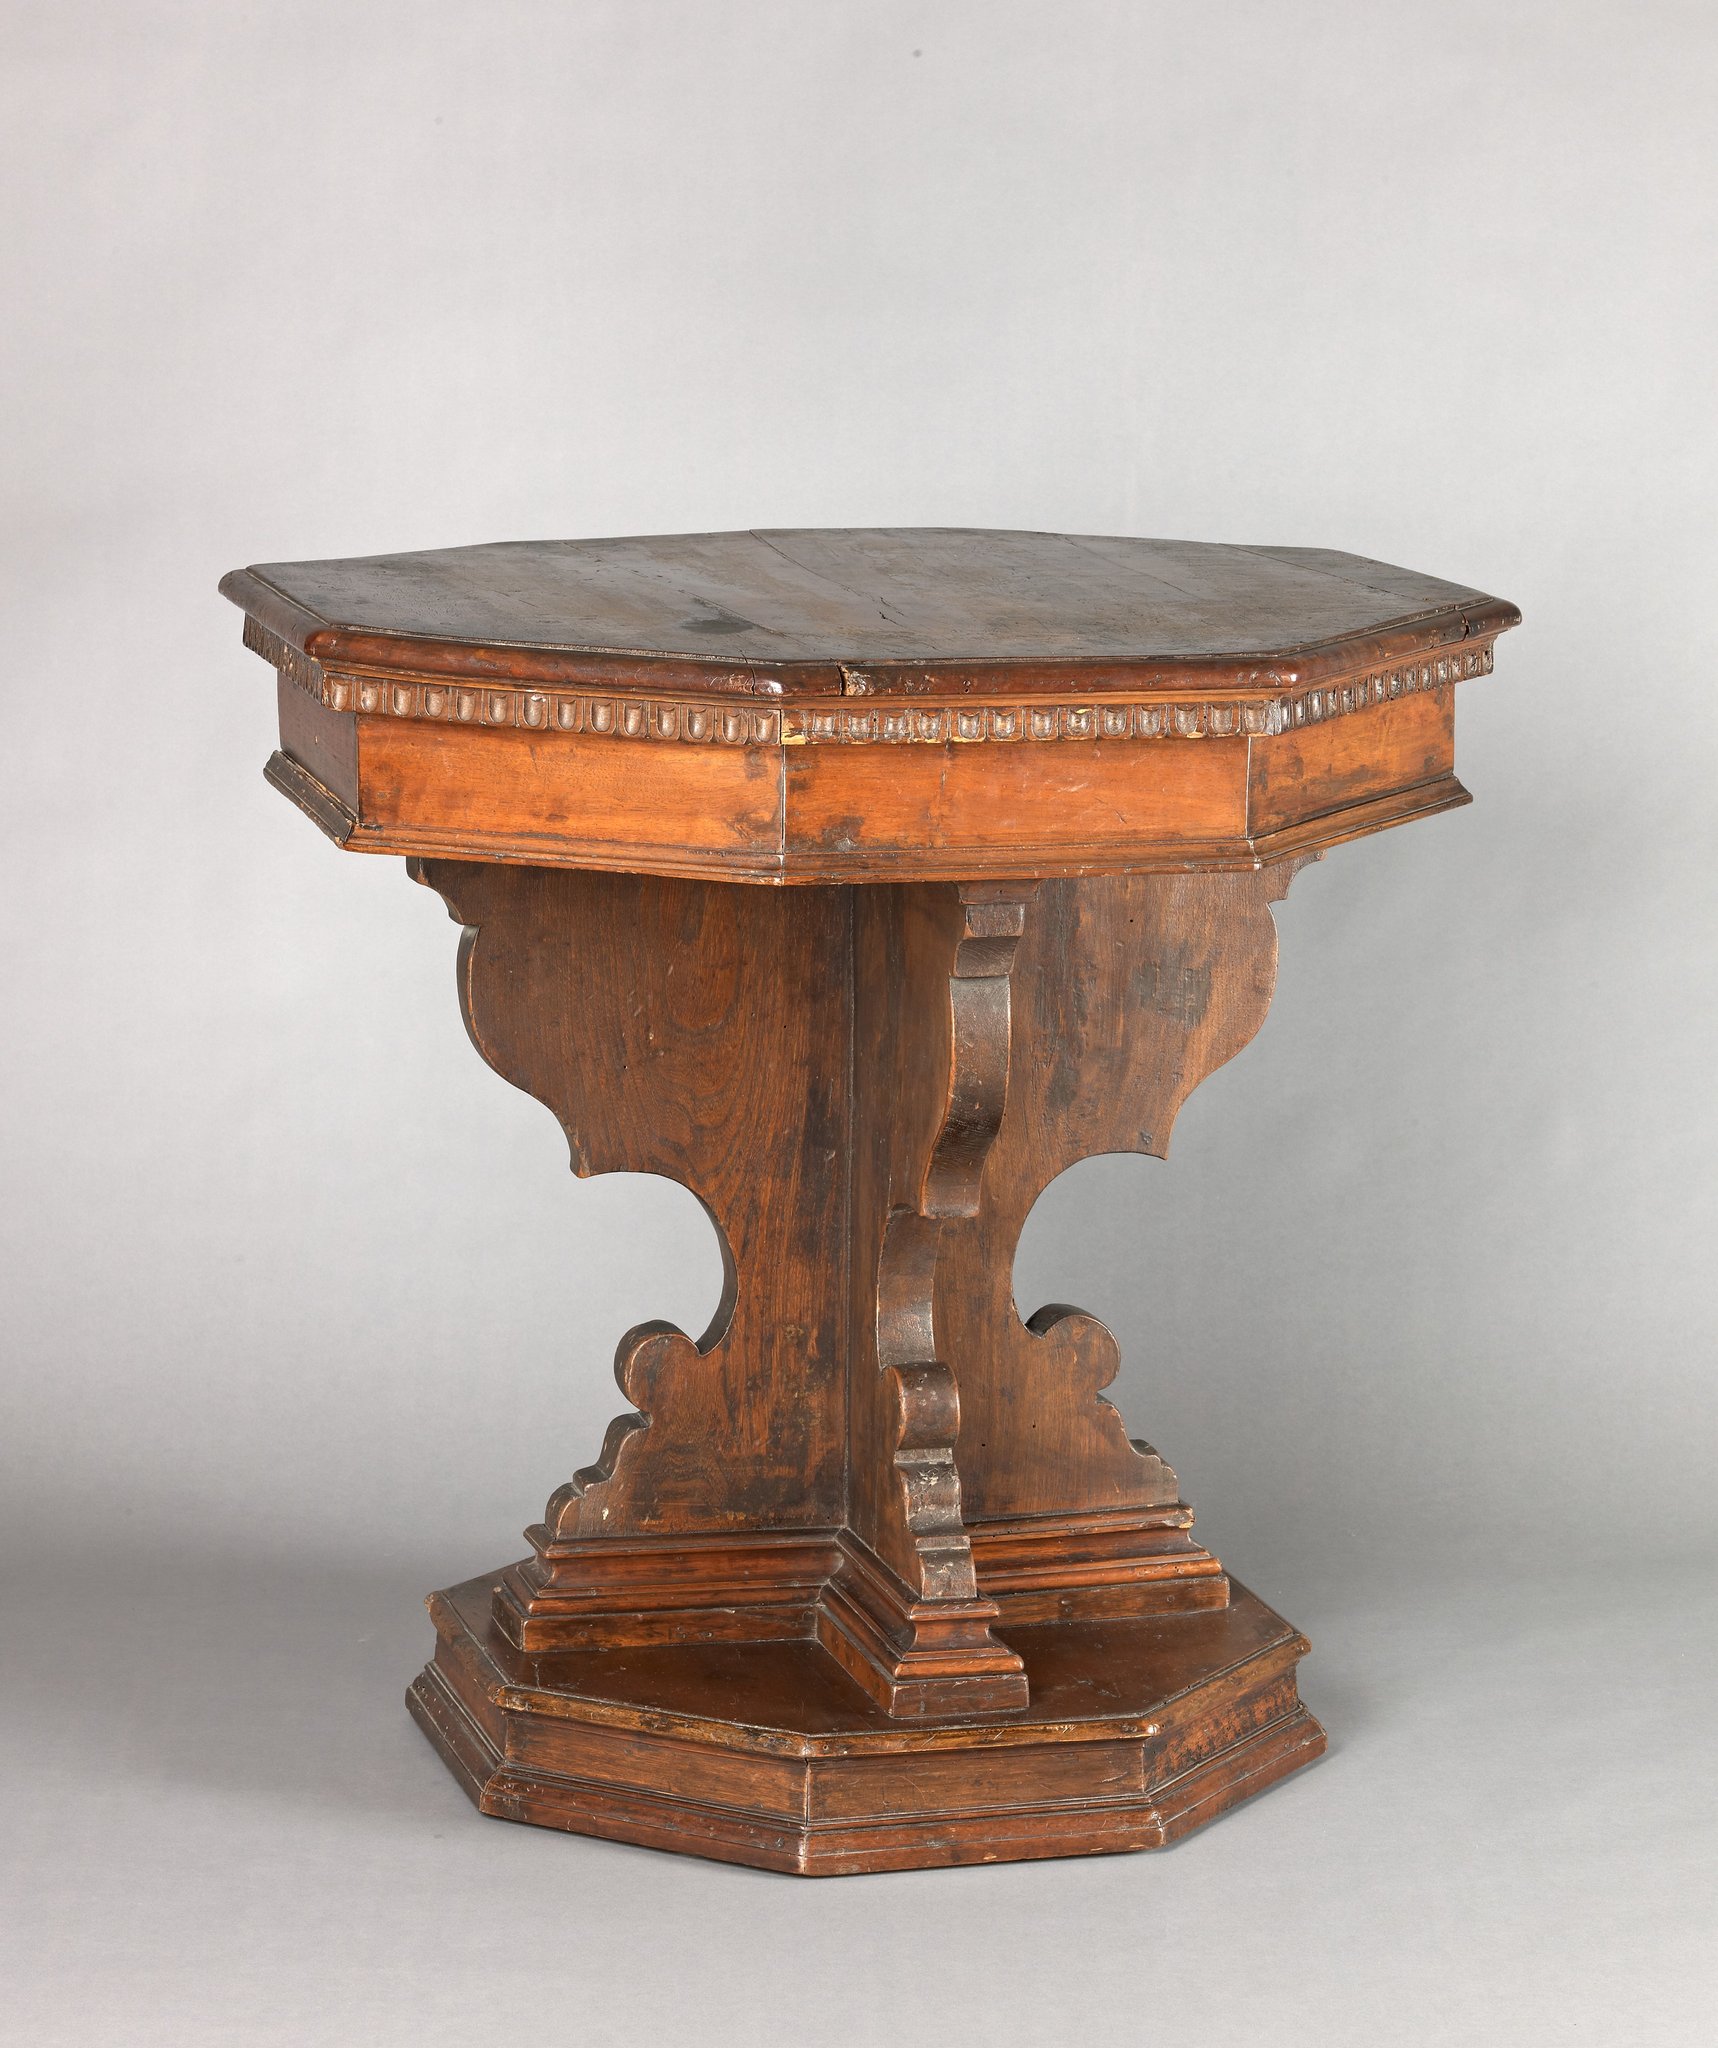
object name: table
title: Small octagonal table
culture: american or italian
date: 1901-1933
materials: wood